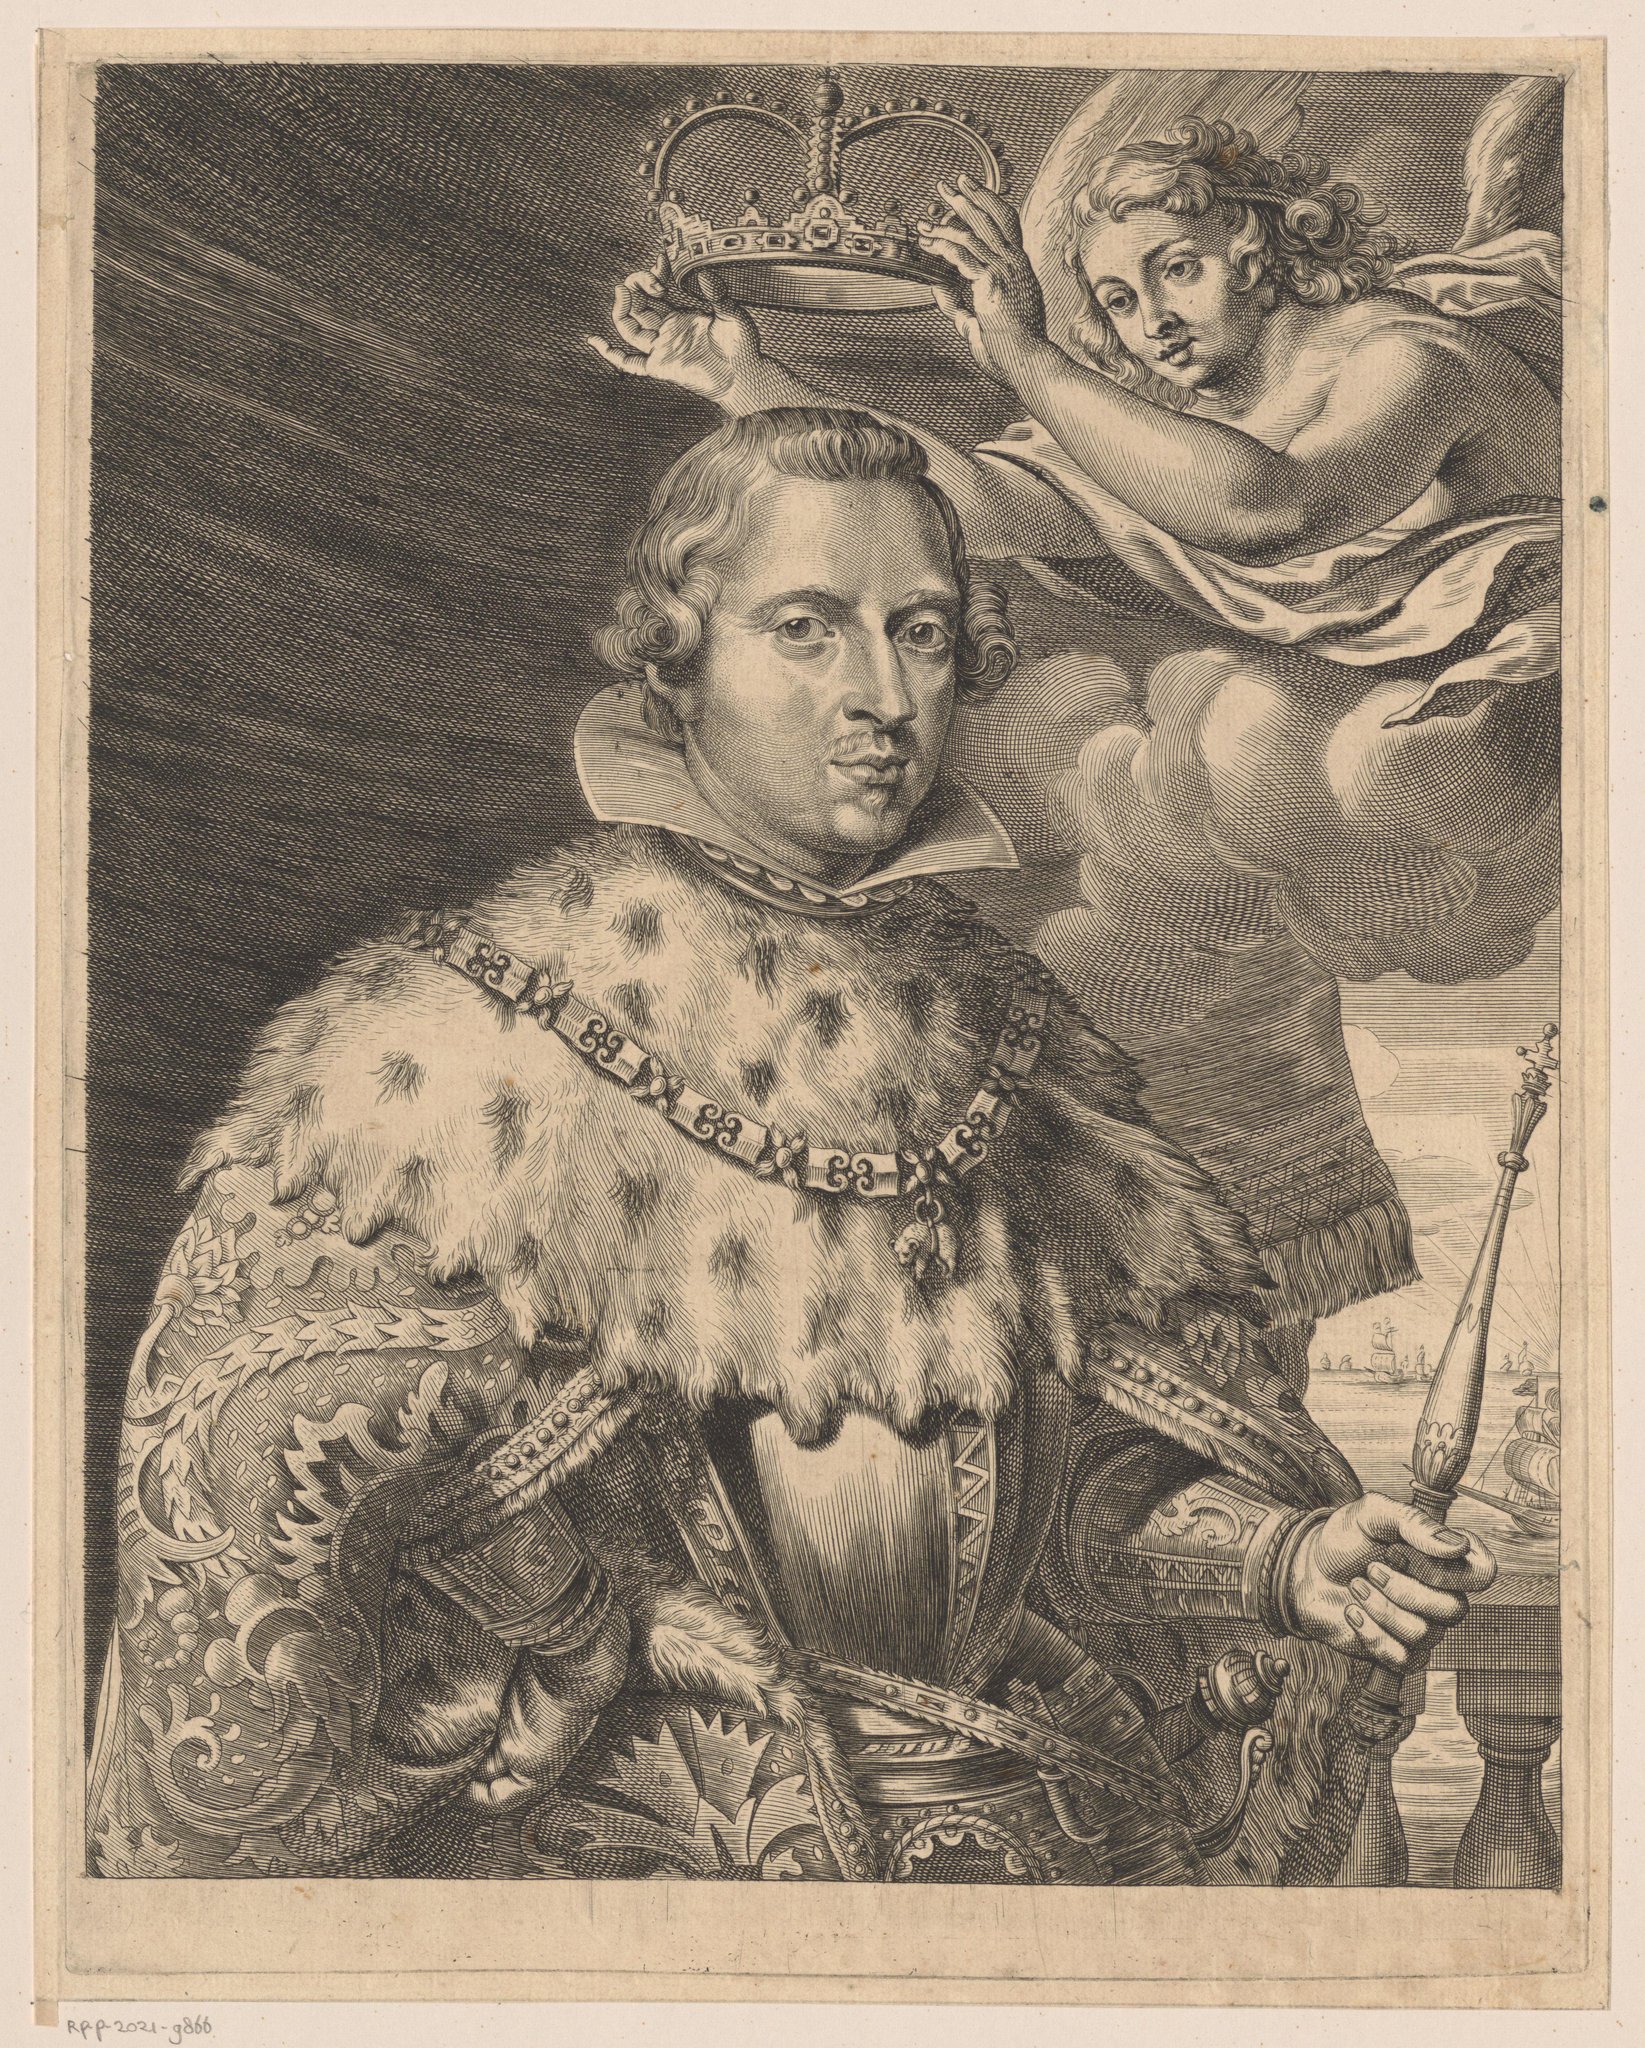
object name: print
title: Sereniss. Fernandi Cardinalis Infantis triumphalis introitus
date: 1636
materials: paper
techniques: engraving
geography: antwerp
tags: filips iv (koning van spanje), crown (symbol of sovereignty), adult man, historical persons, knighthood order of the golden fleece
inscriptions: collector's mark: Lugt 240